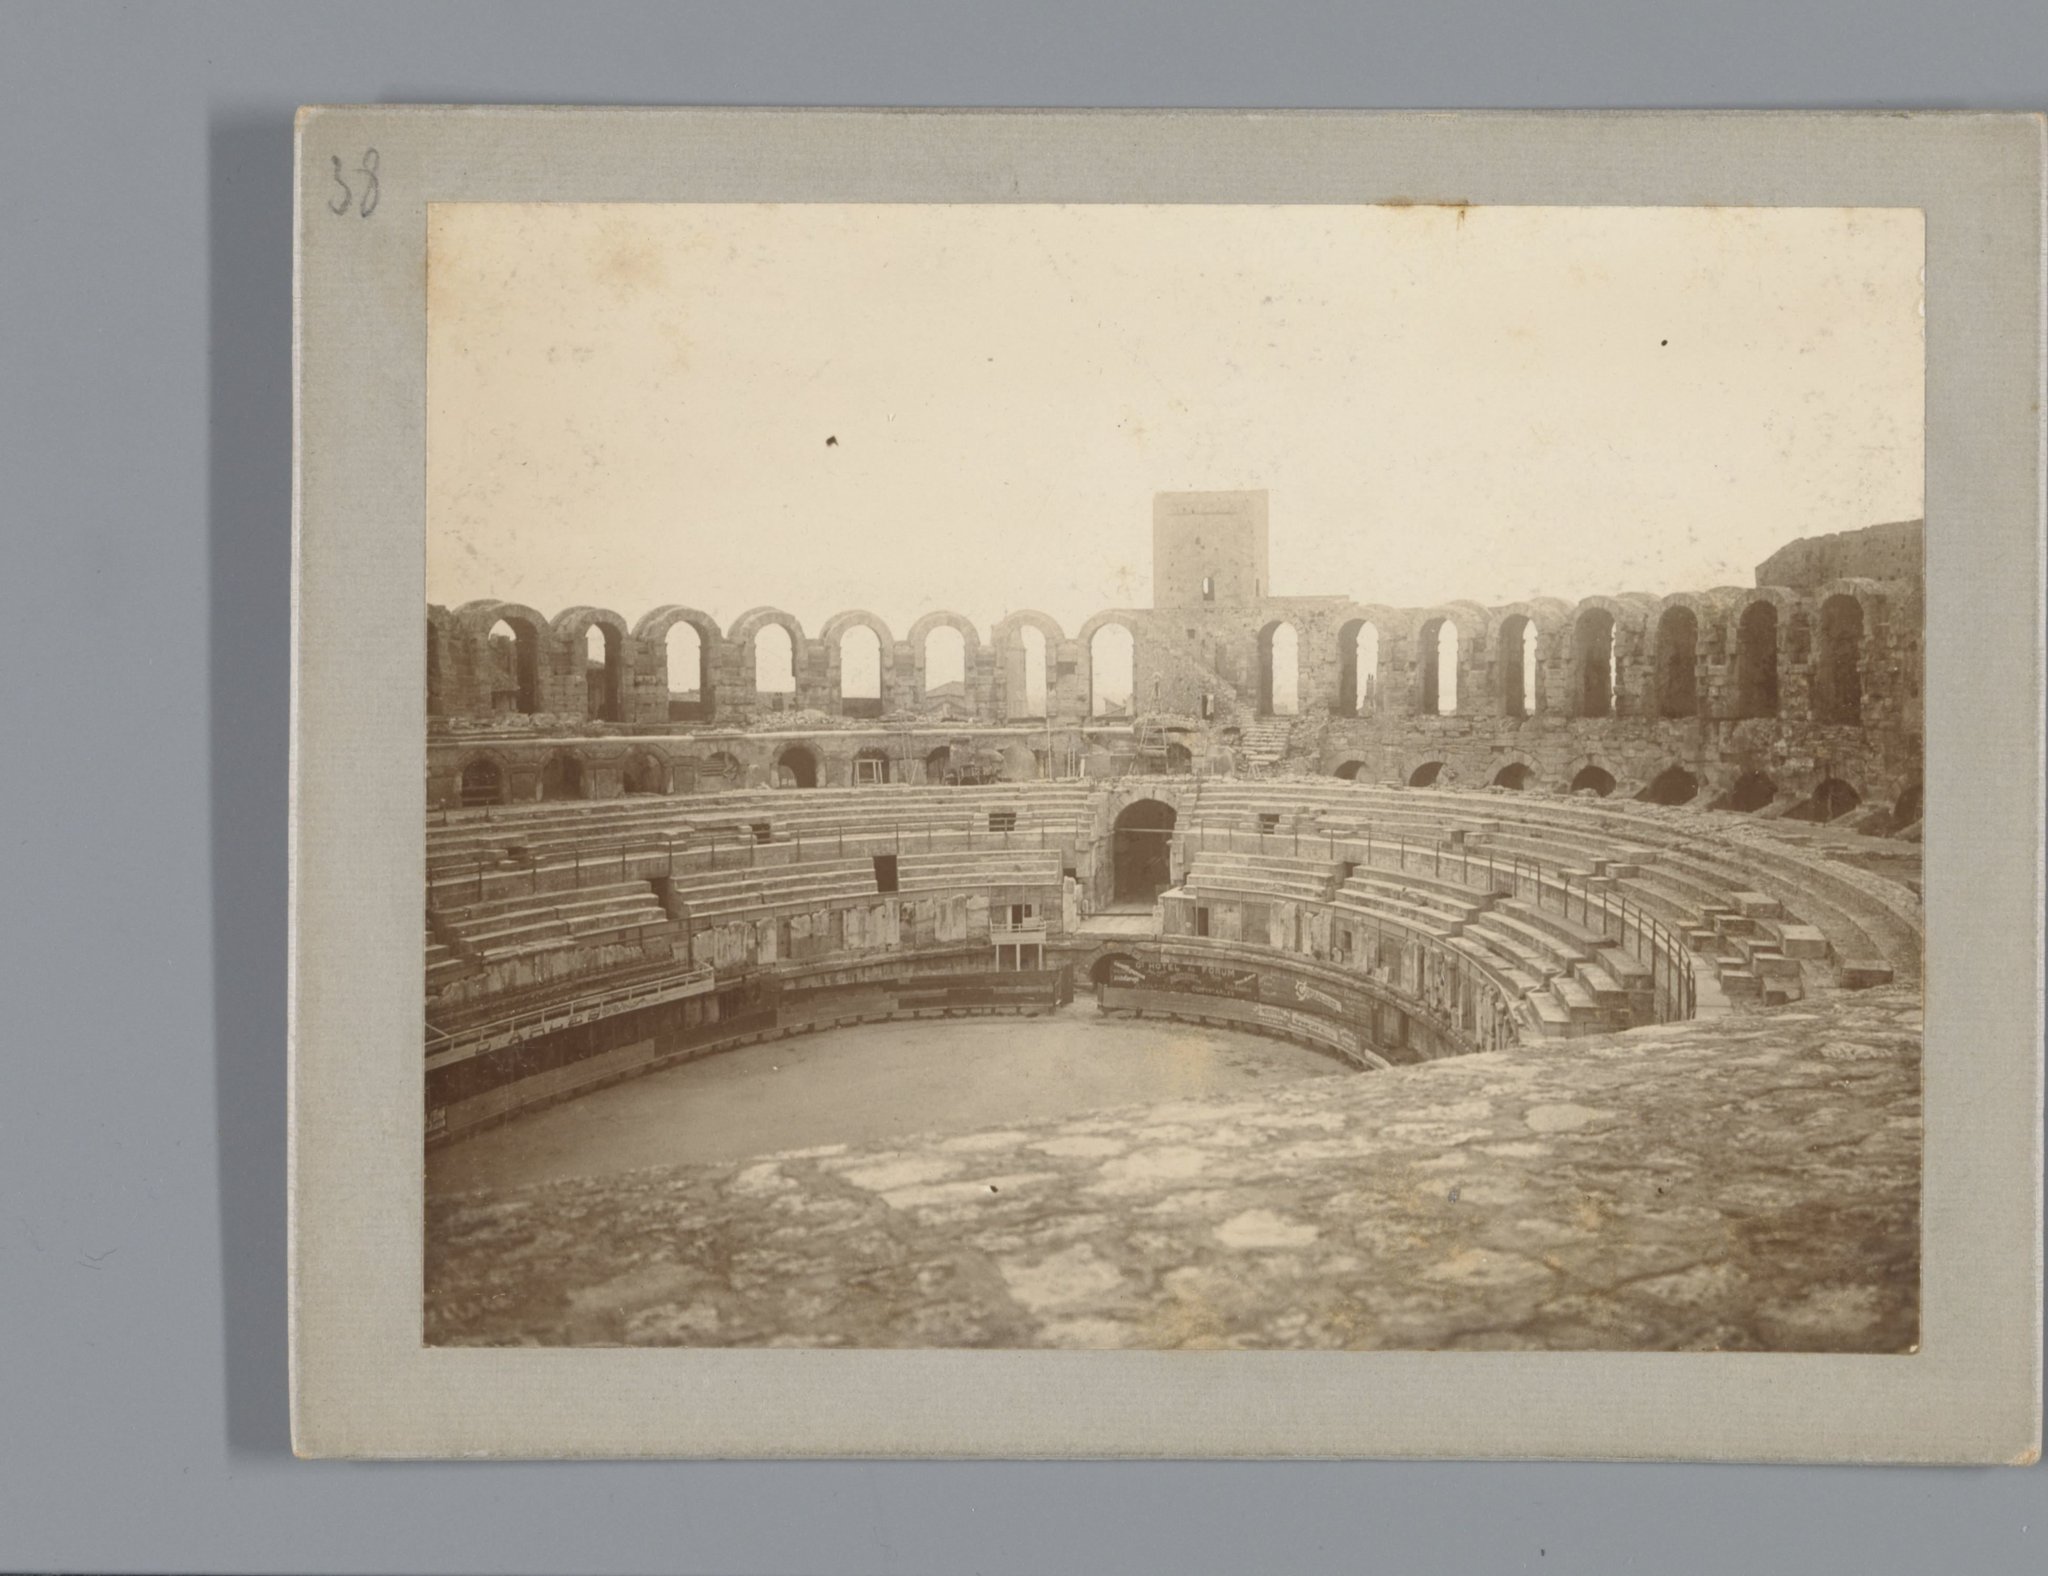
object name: photograph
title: Arena te Arles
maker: willem witsen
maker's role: draughtsman, painter, print maker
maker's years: 1860-1923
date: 1860-1915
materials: cardboard, paper, photographic support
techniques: gelatin silver print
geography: arles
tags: arena van arles